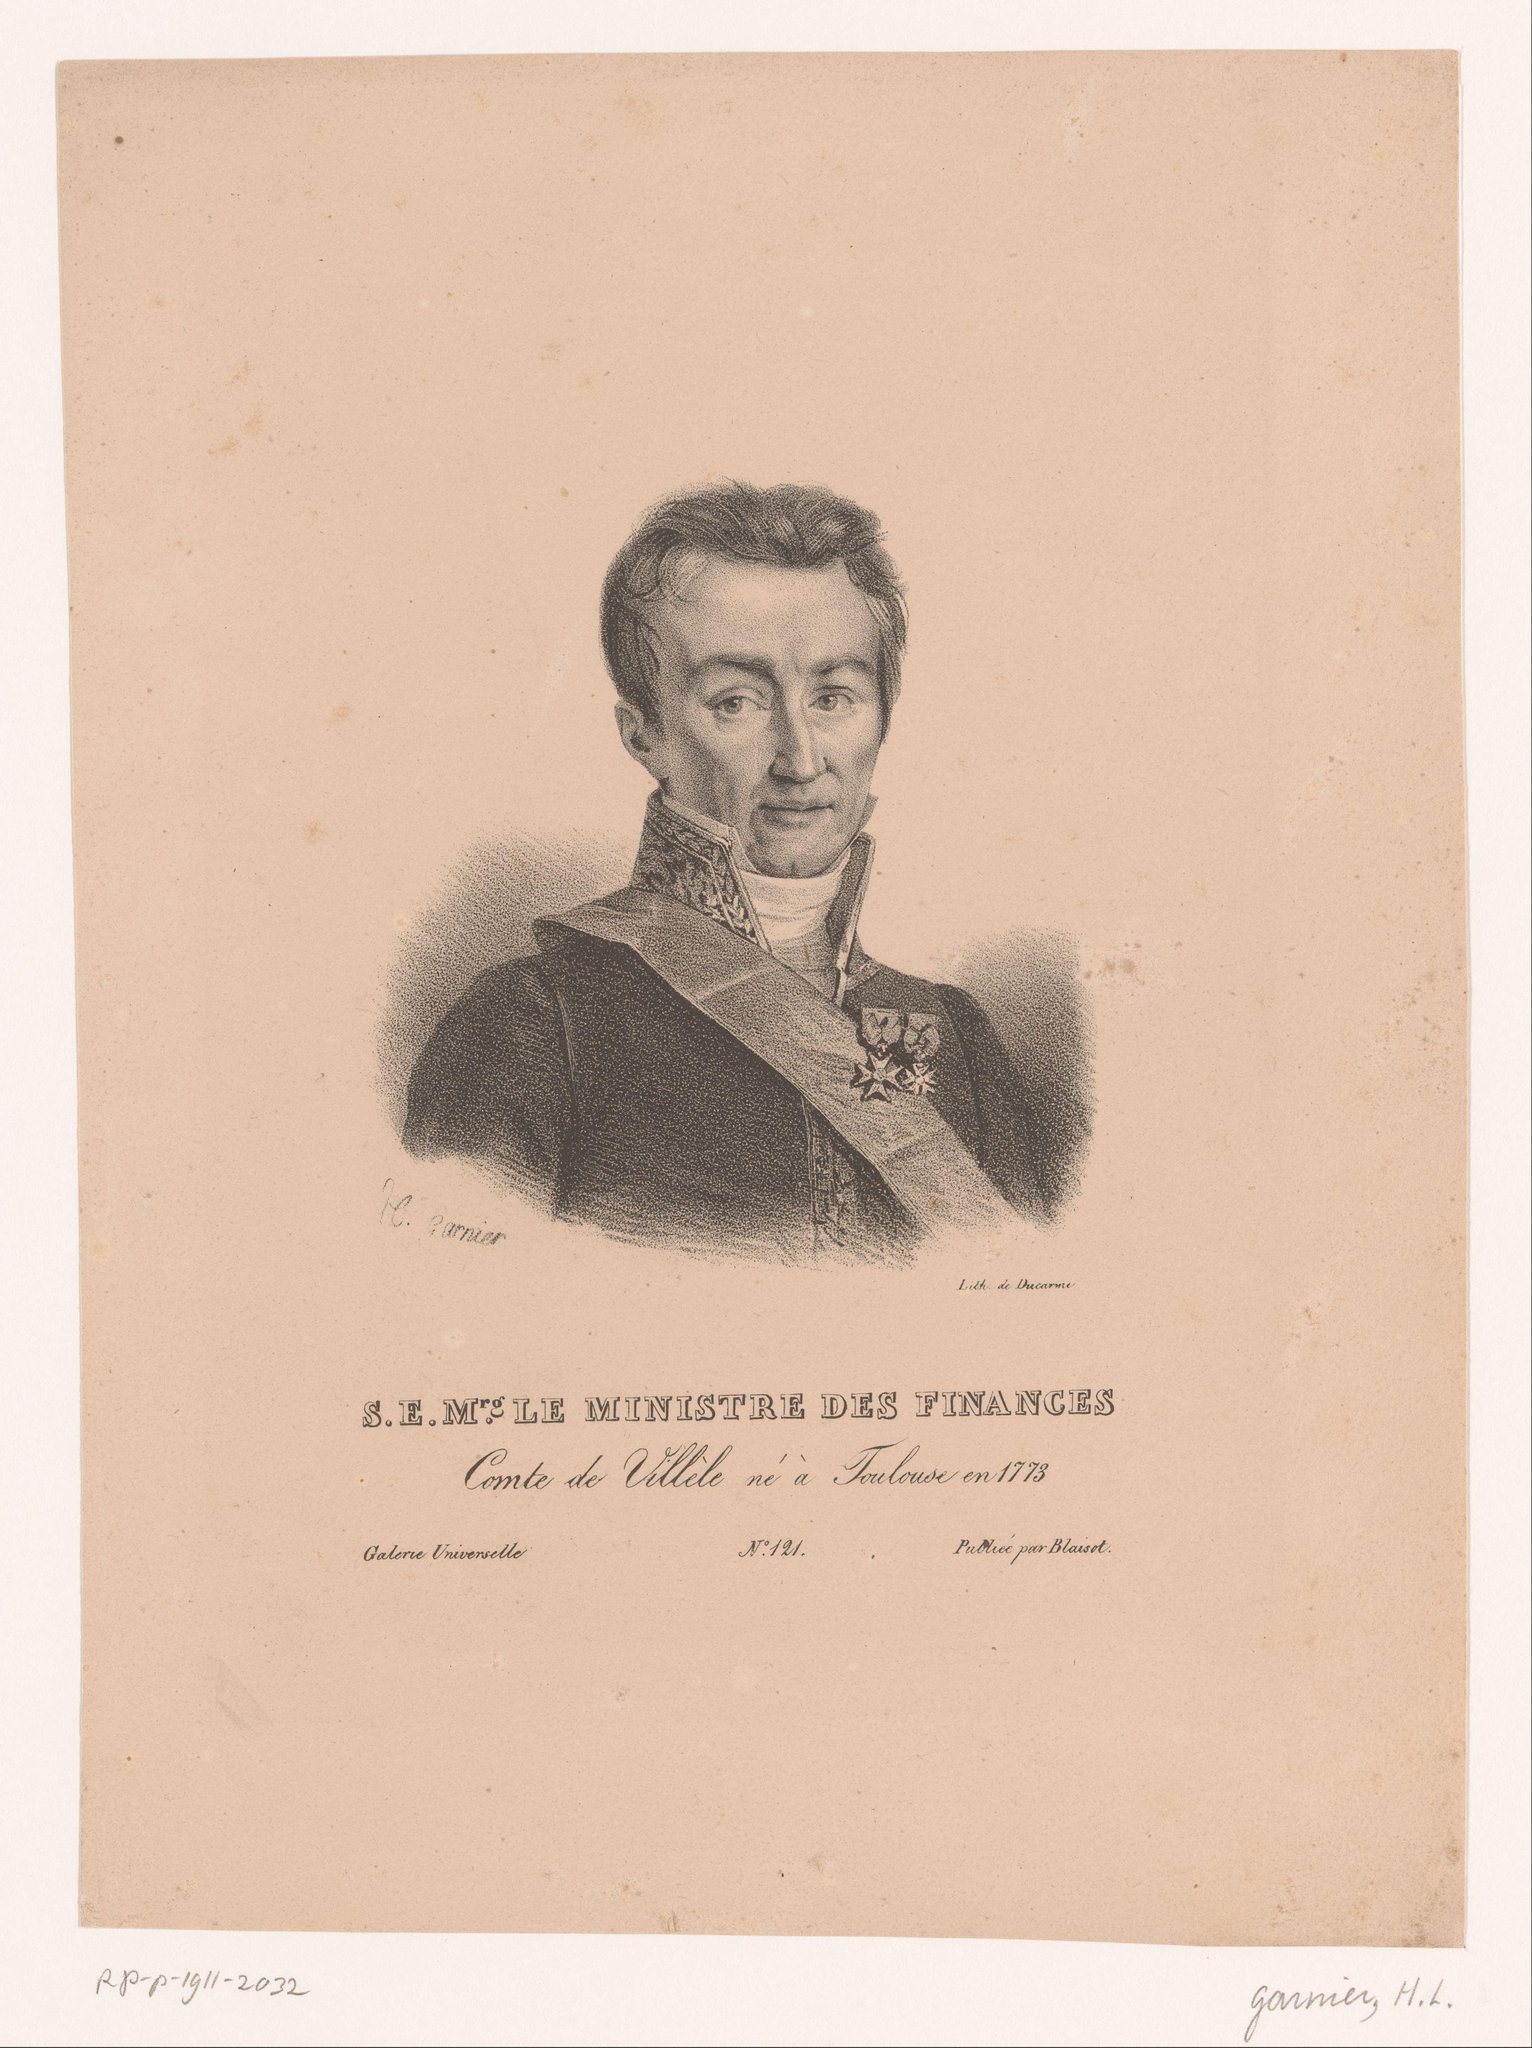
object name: print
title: S.E.Mrg. le Ministre des Finances, Comte de Villèle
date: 1823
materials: paper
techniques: lithograph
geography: paris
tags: mayor, historical persons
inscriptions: collector's mark: Lugt 2228a